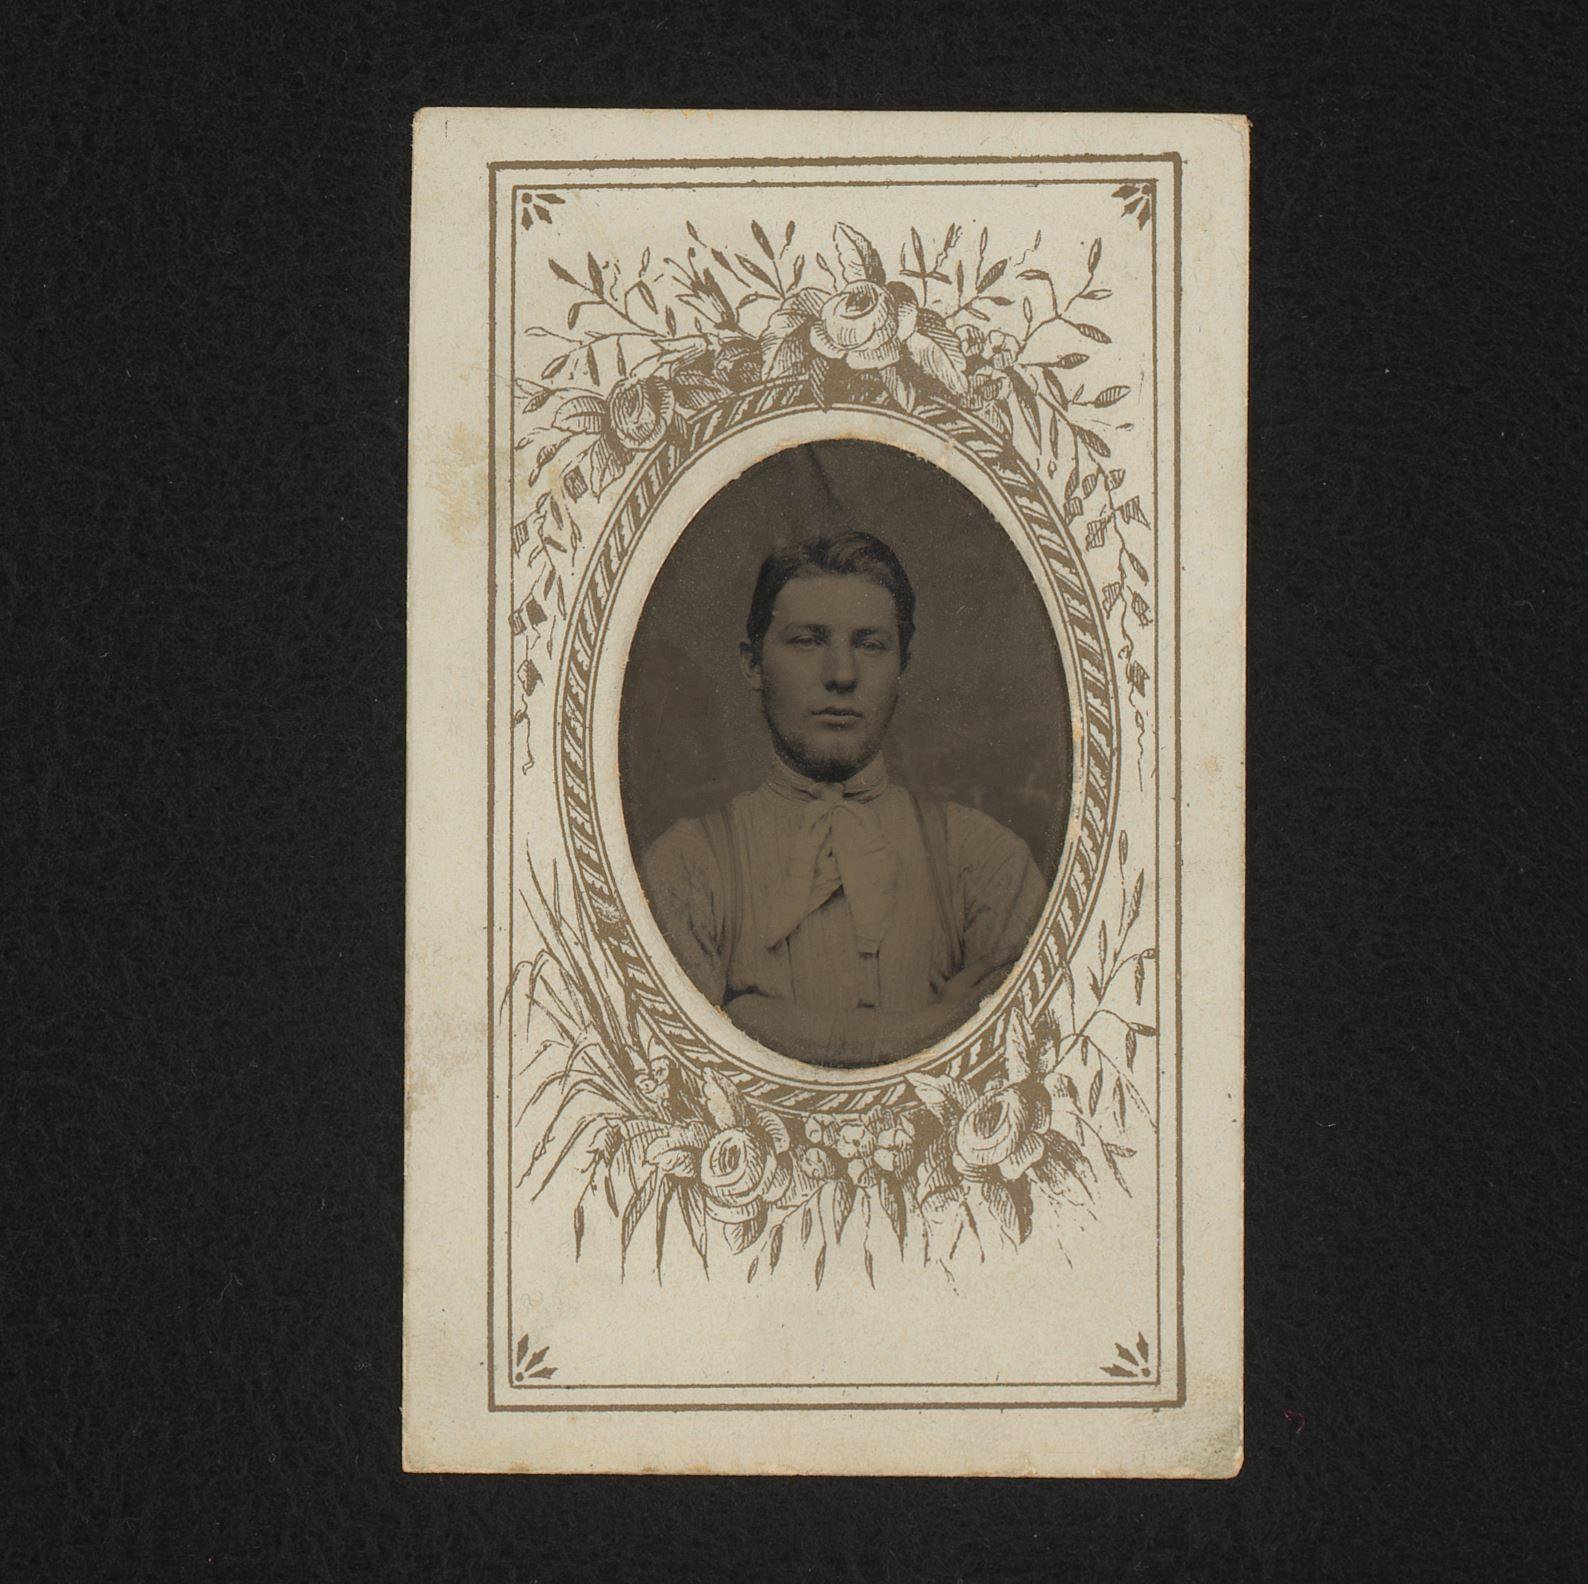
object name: carte de visite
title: Portret van een man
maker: Anonymous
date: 1870-1882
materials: cardboard, iron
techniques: ferrotyping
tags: adult man, historical persons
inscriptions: inscription: ‘Hammond's Victoria Cartes de visite/ taken and finished in a few minutes. (...)’